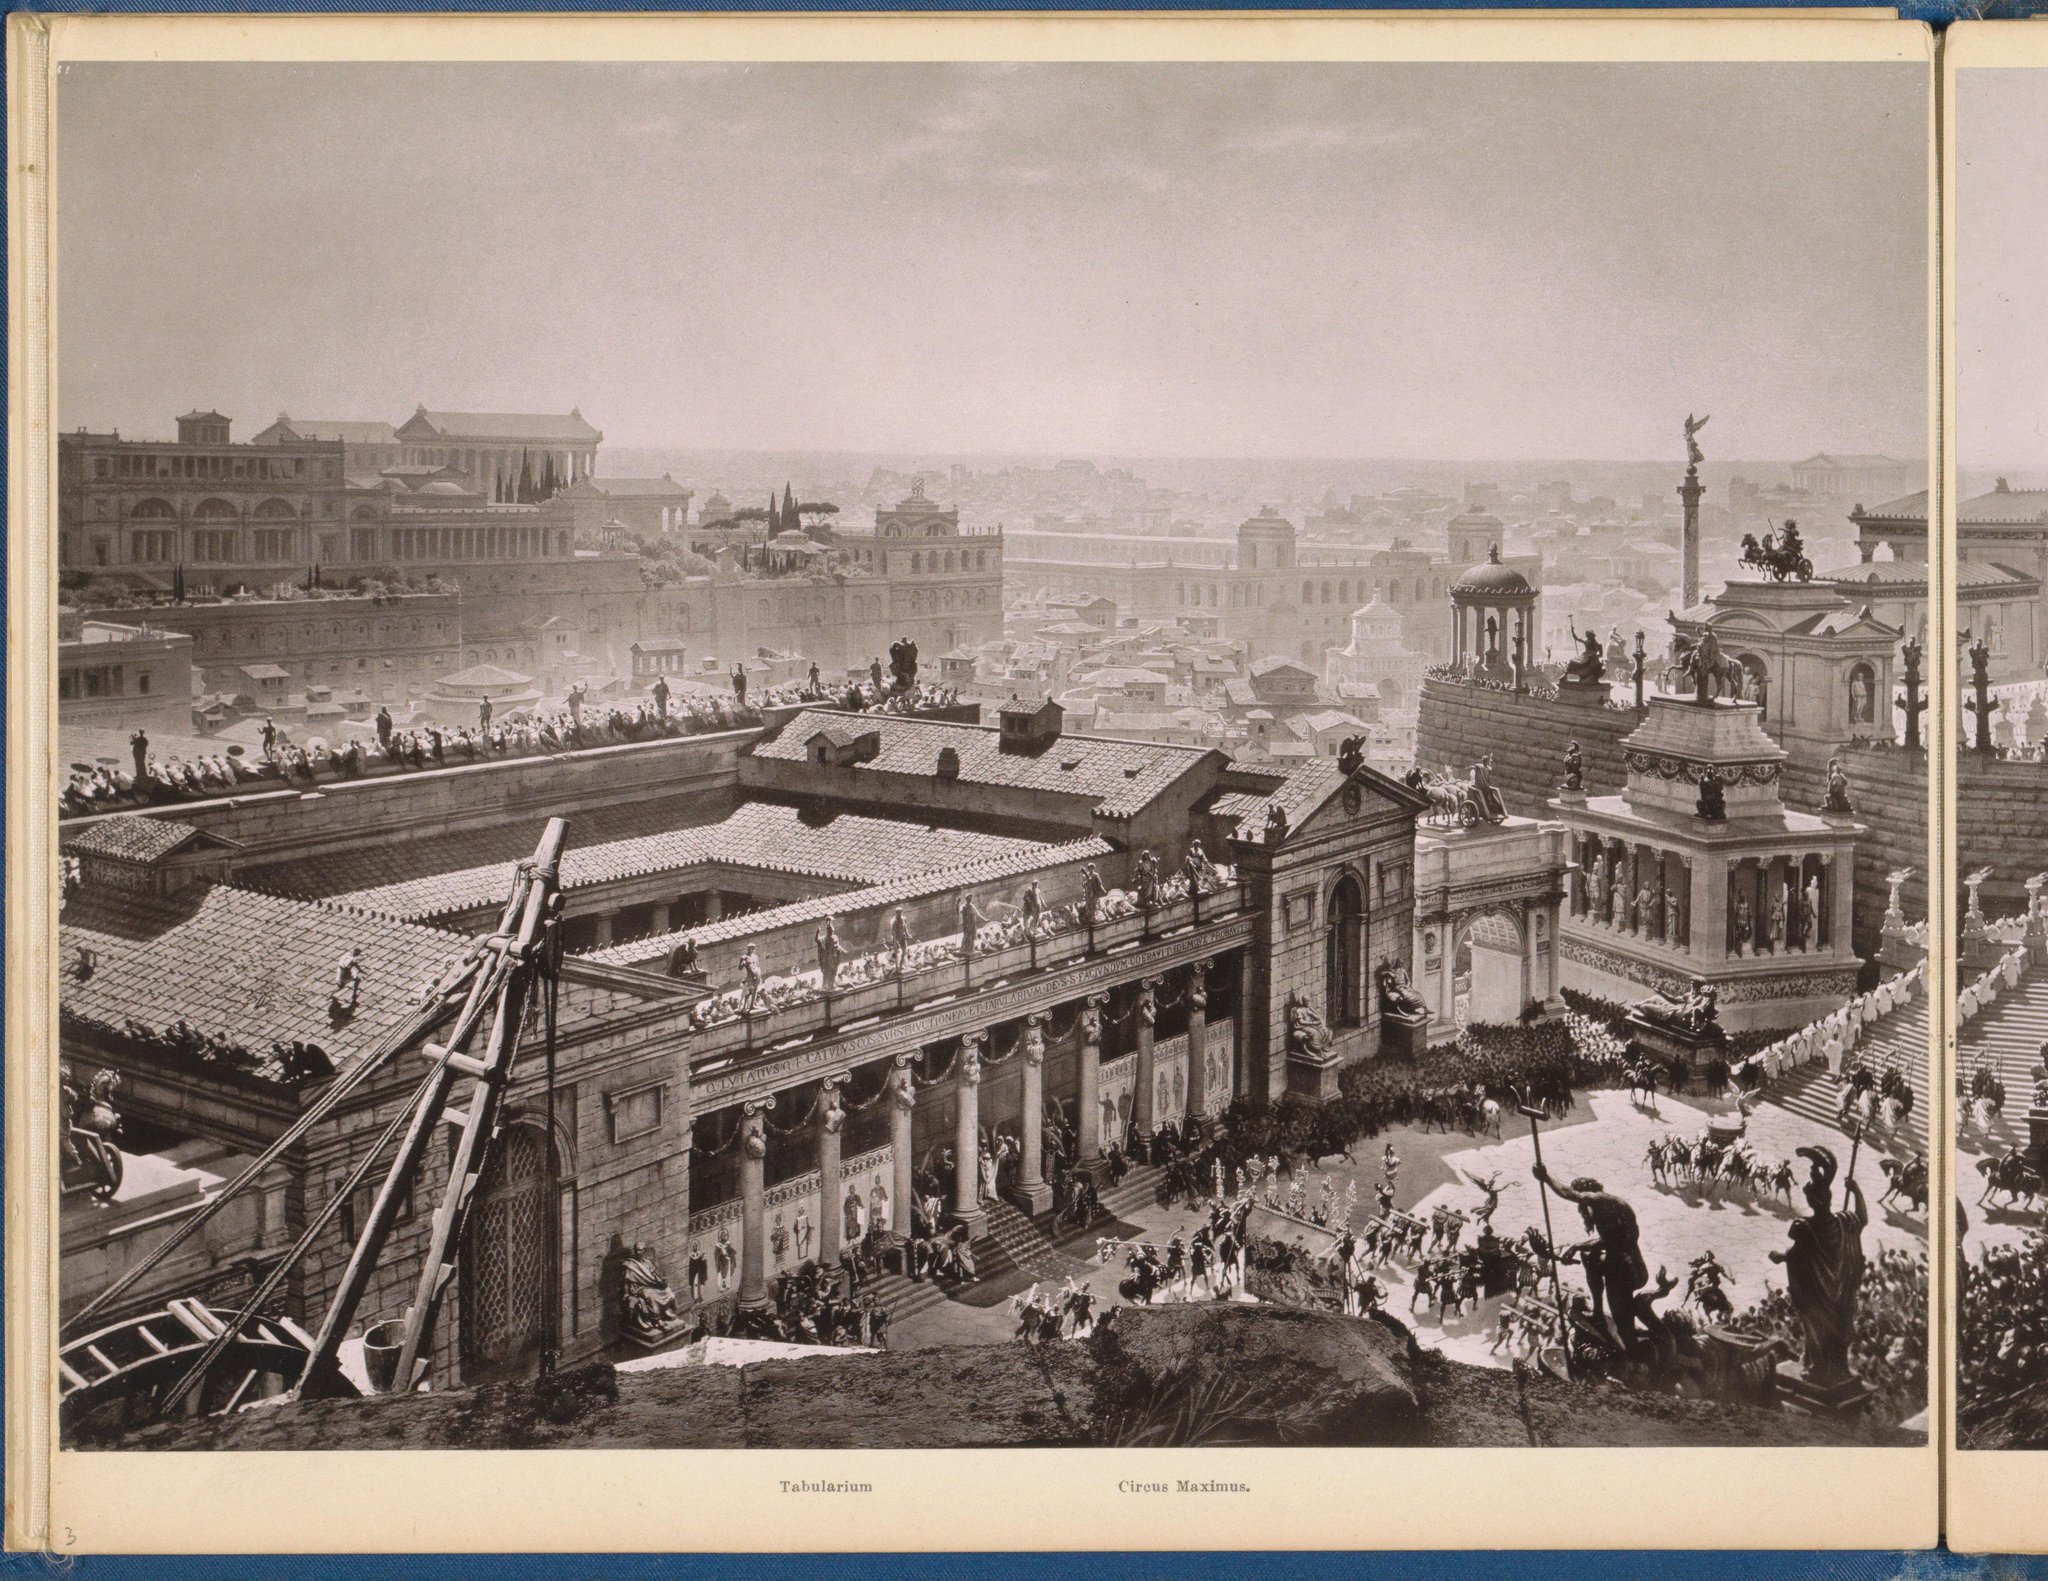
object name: photograph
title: Tabularium - Circus Maximus.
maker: franz seraph hanfstaengl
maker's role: painter, print maker, printer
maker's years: 1804-1877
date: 1890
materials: cardboard, paper, ink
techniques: photograph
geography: munich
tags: archive, grounds, fields and accomodations for sports, games and physical performances (+ out of doors (sports, games, etc.)), exterior ~ representation of a building, treadmill, prospect of city, town panorama, silhouette of city, rome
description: Onderdeel van Panorama van het oude Rome.